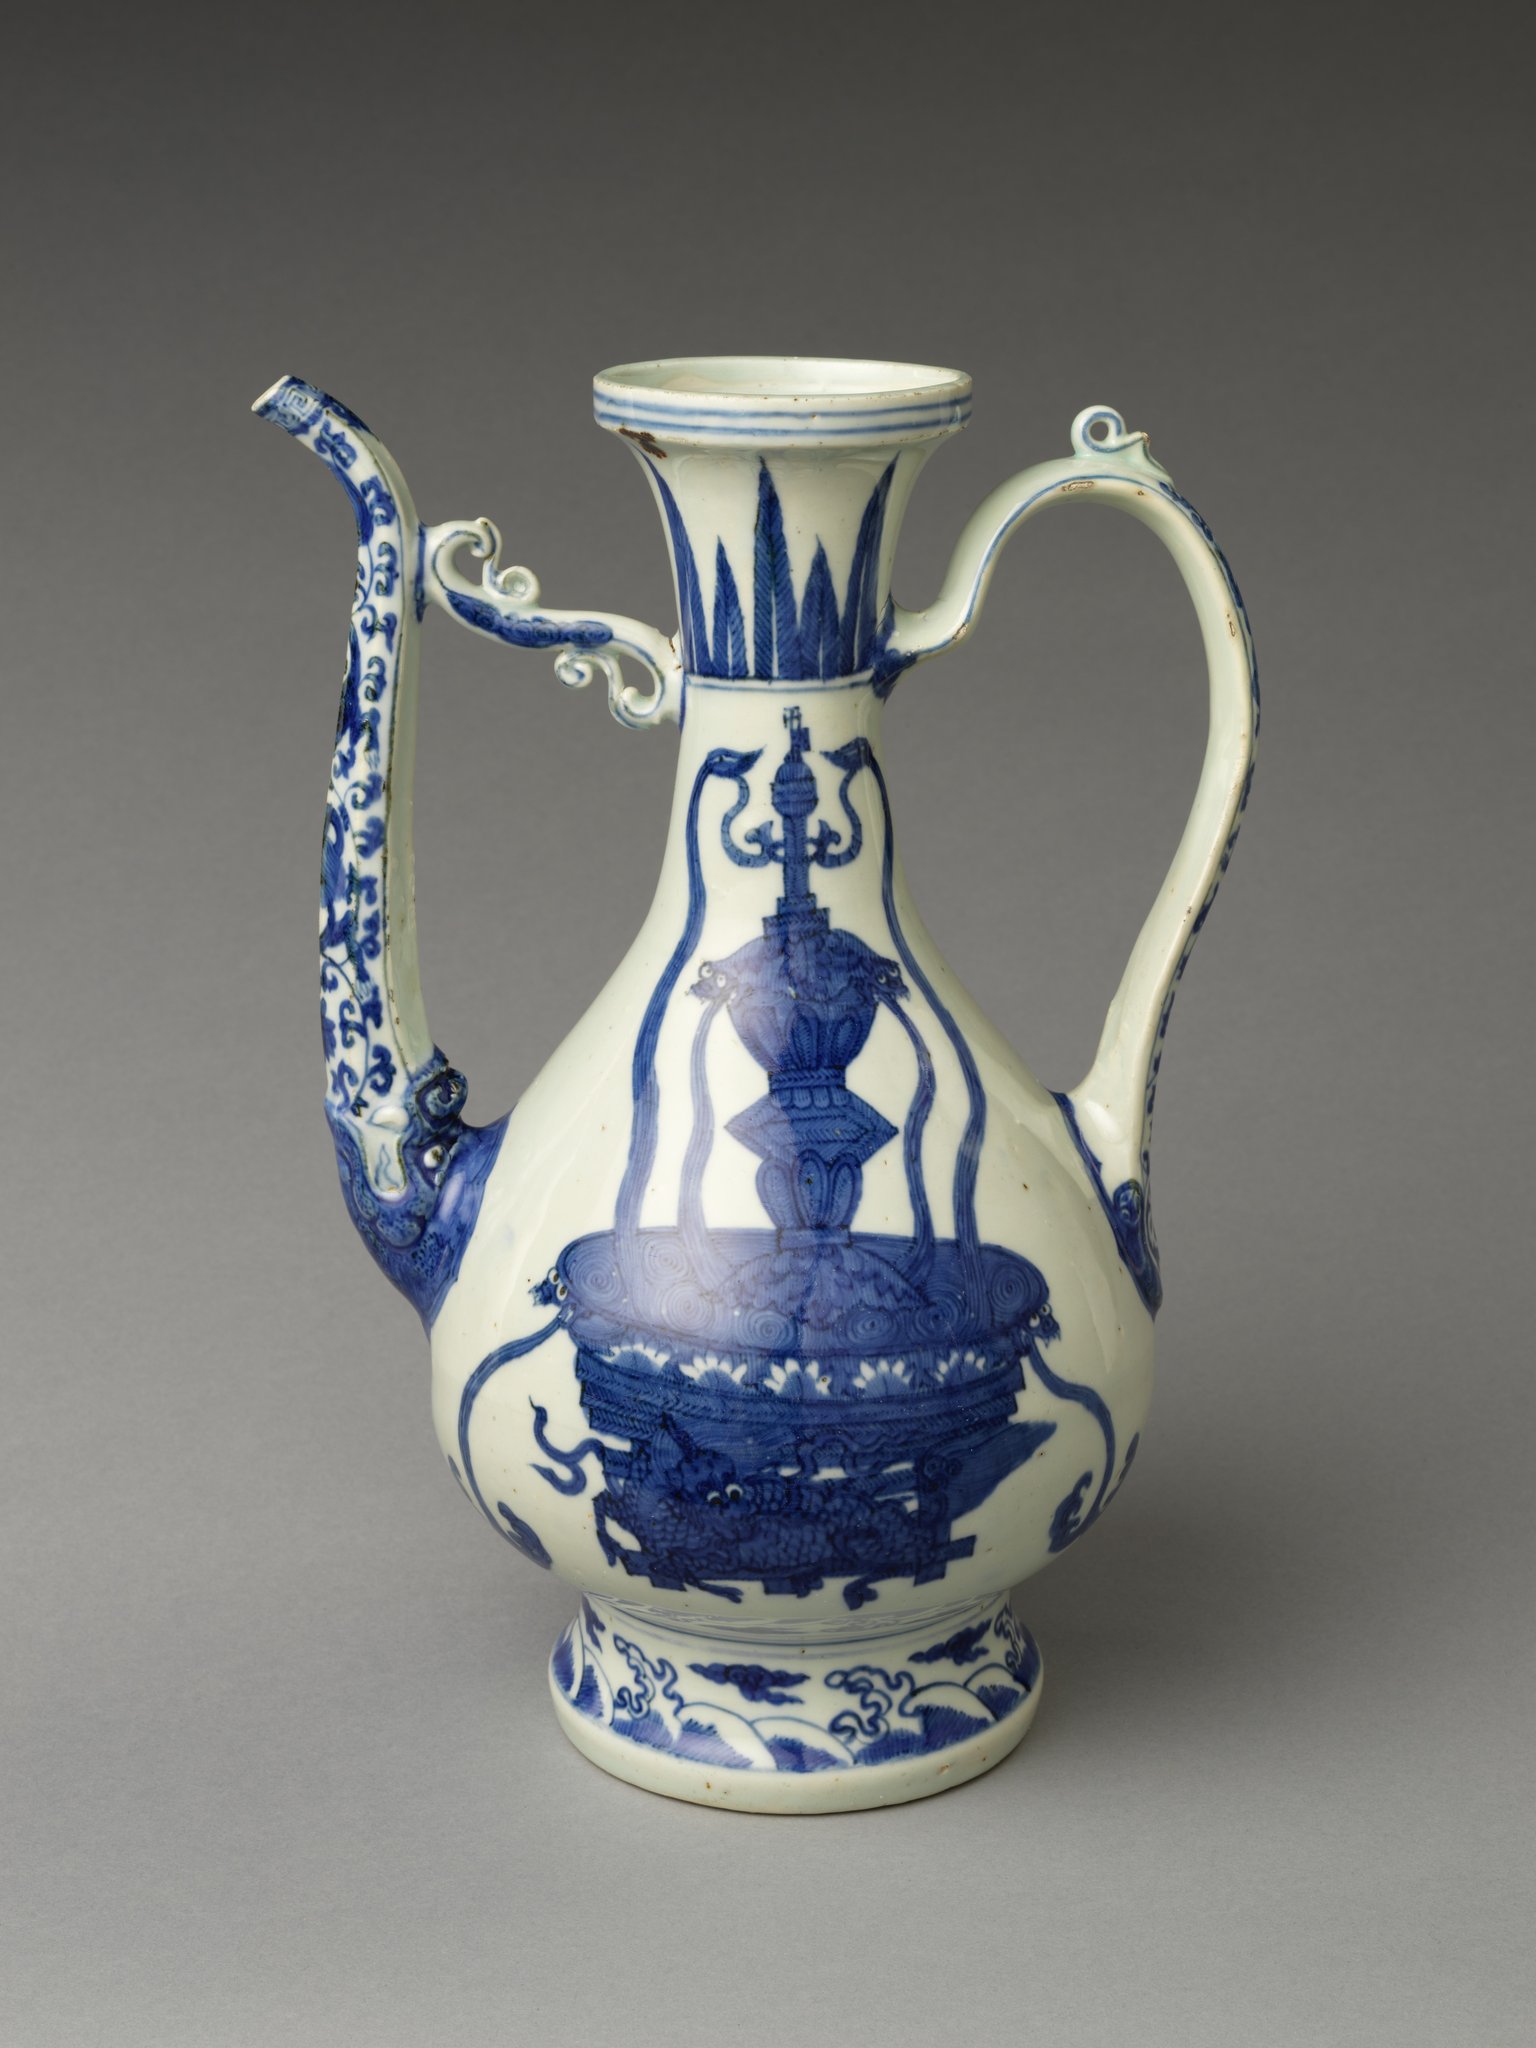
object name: ewer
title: “Magic Fountain” ewer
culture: chinese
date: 1534-1566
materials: cobalt, porcelain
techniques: painting, underglaze